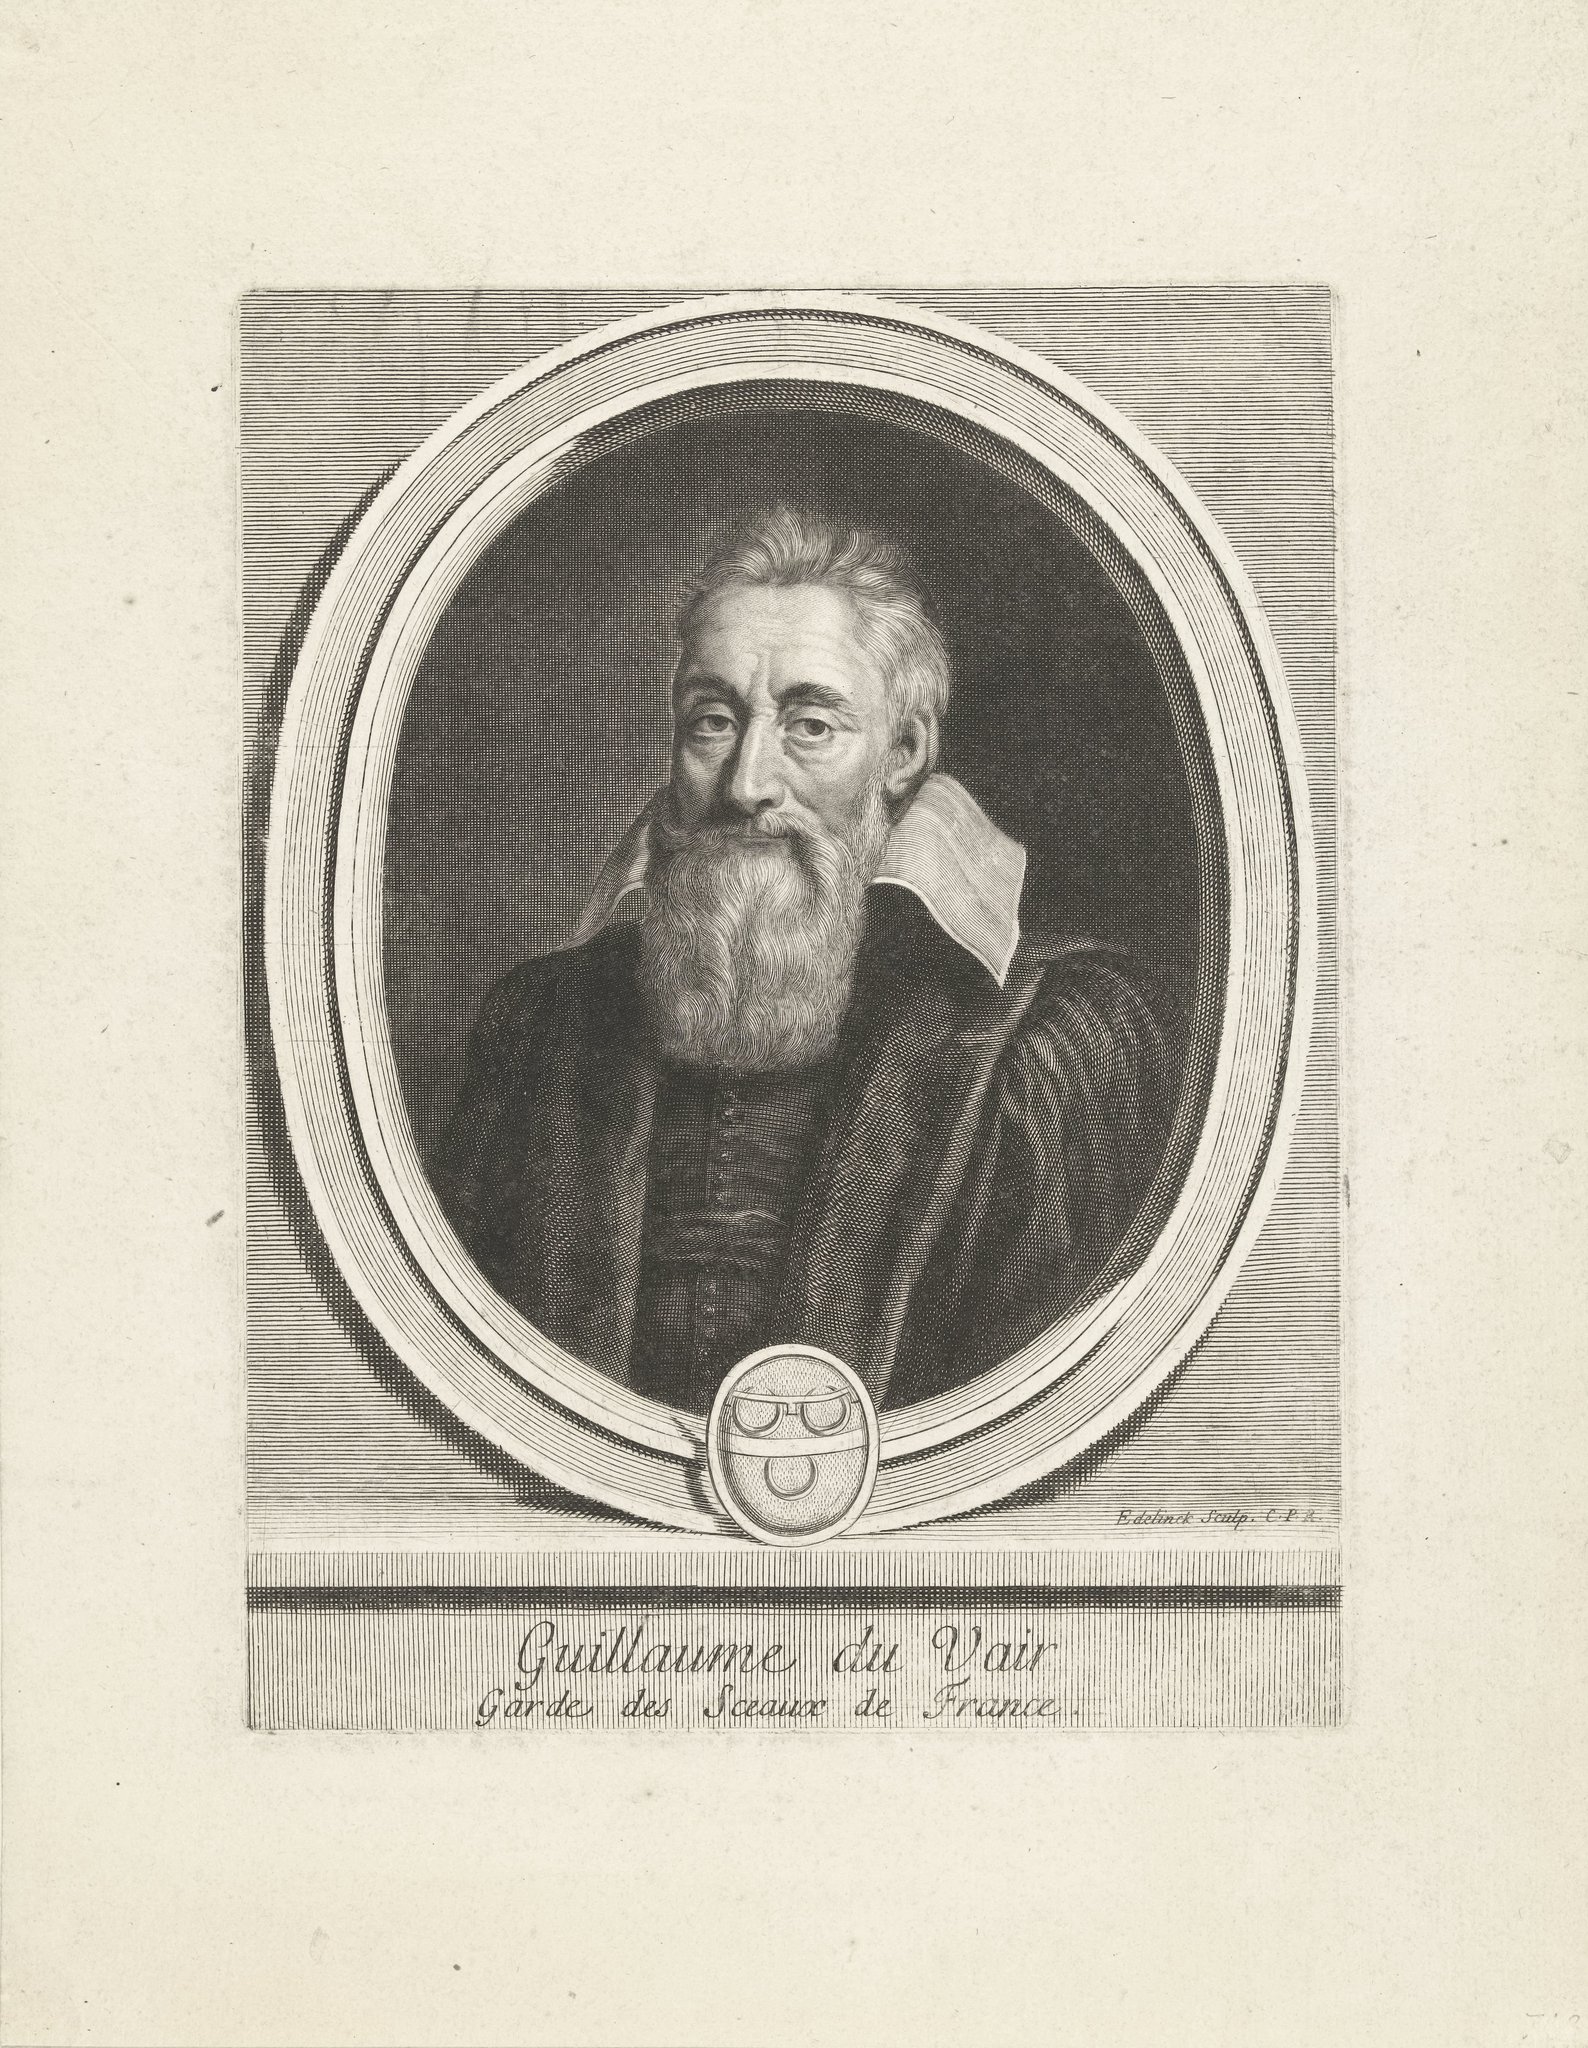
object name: print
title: Portret van Guillaume du Vair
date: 1666-1707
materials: paper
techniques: engraving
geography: france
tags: paris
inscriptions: inscription: ‘donnez de ...nette edelinck par moy (?) Chevalier’, collector's mark: Lugt 240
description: Portret van Guillaume du Vair (1556-1621), grootzegelbewaarder van Frankrijk en bisschop van Lisieux, afgebeeld in ovale omlijsting met wapen.